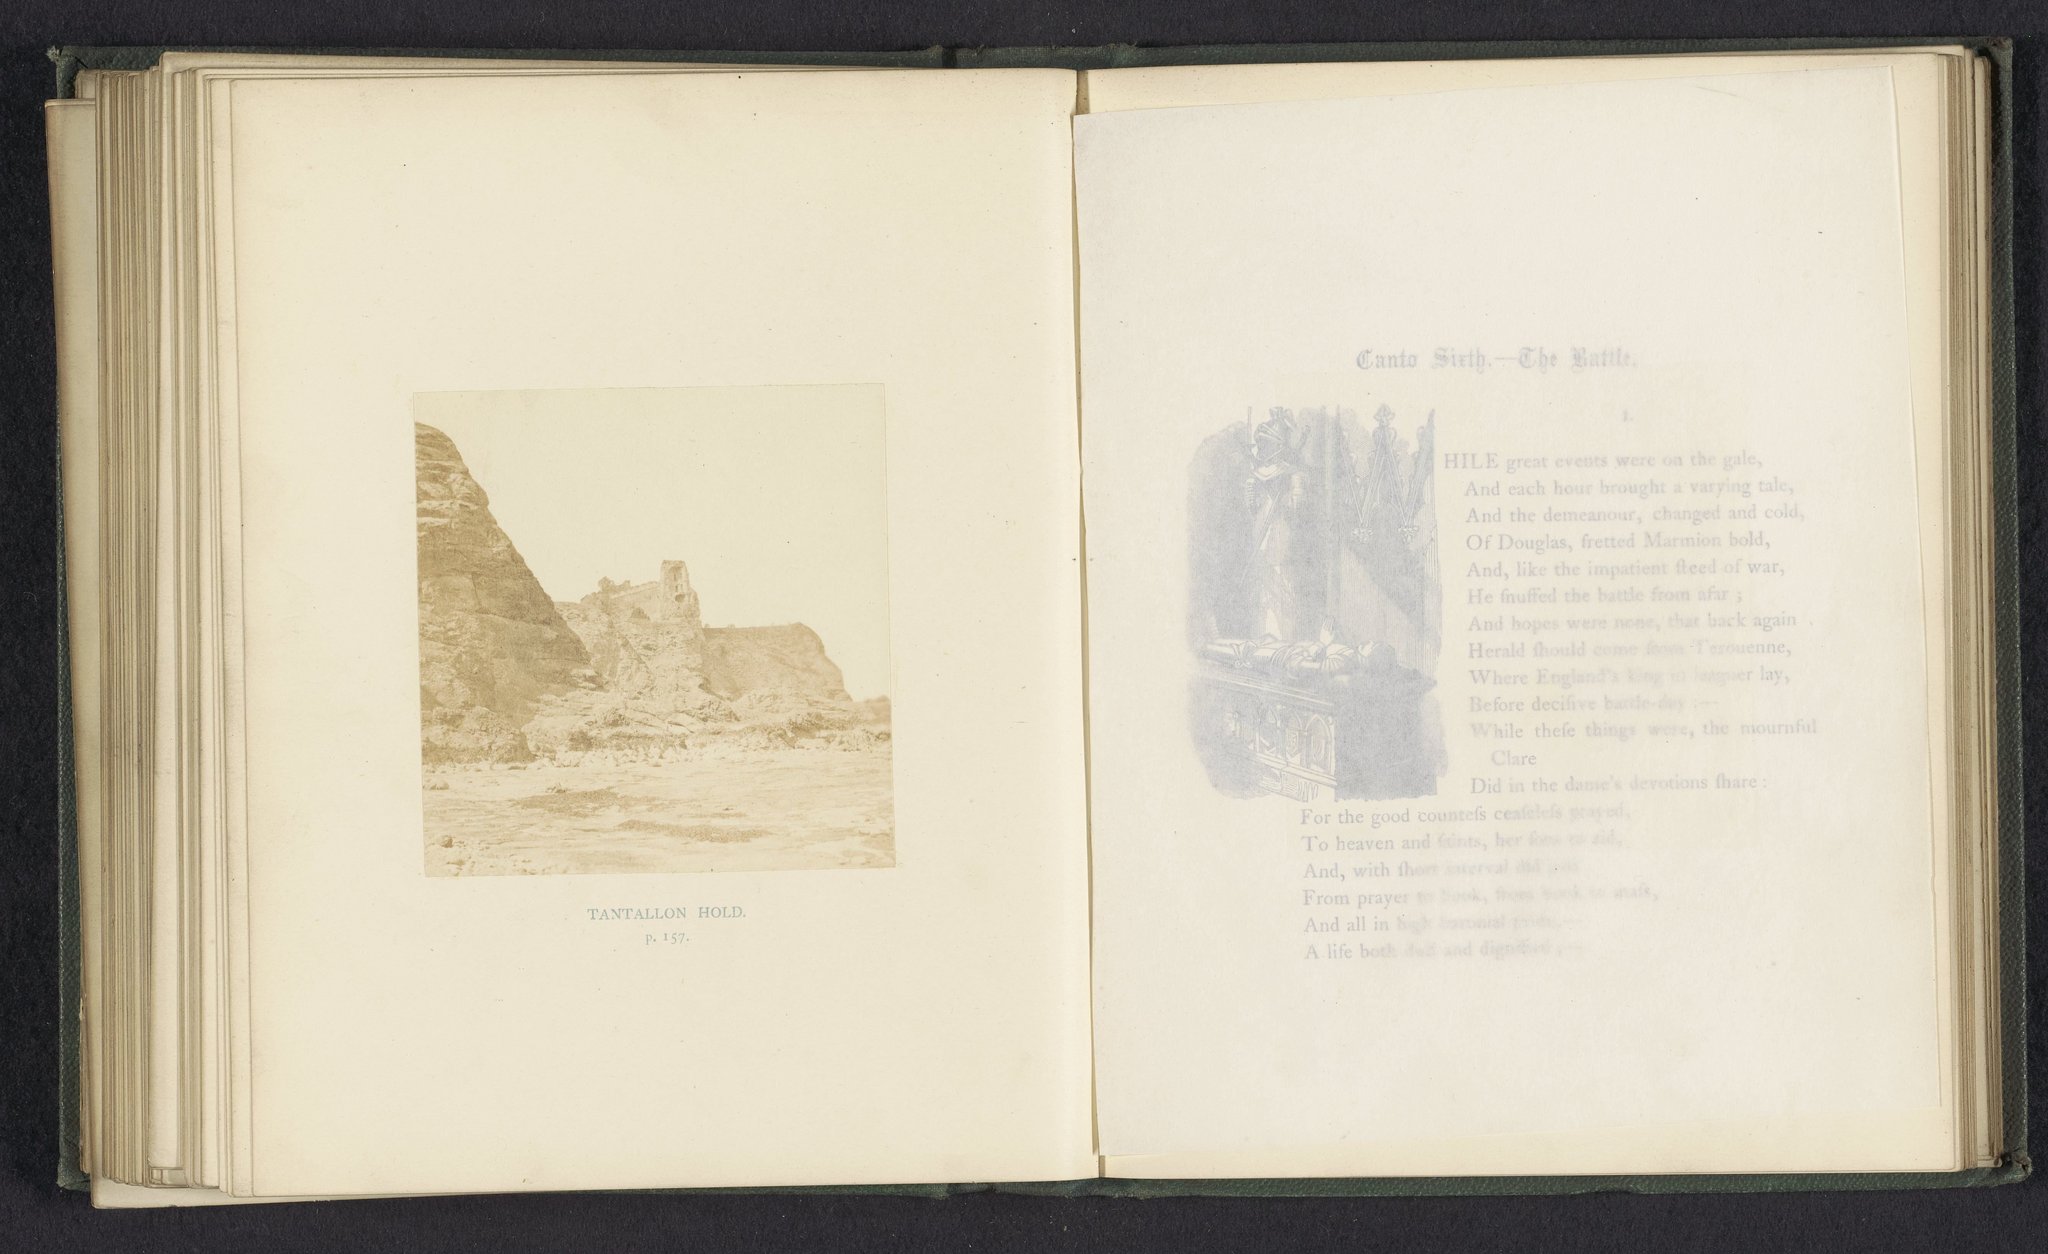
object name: page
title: Tantallon Hold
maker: thomas annan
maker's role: fotograaf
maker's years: 1829-1887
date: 1861-1866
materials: photographic support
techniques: albumen print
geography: scottish borders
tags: castle, rocky coast